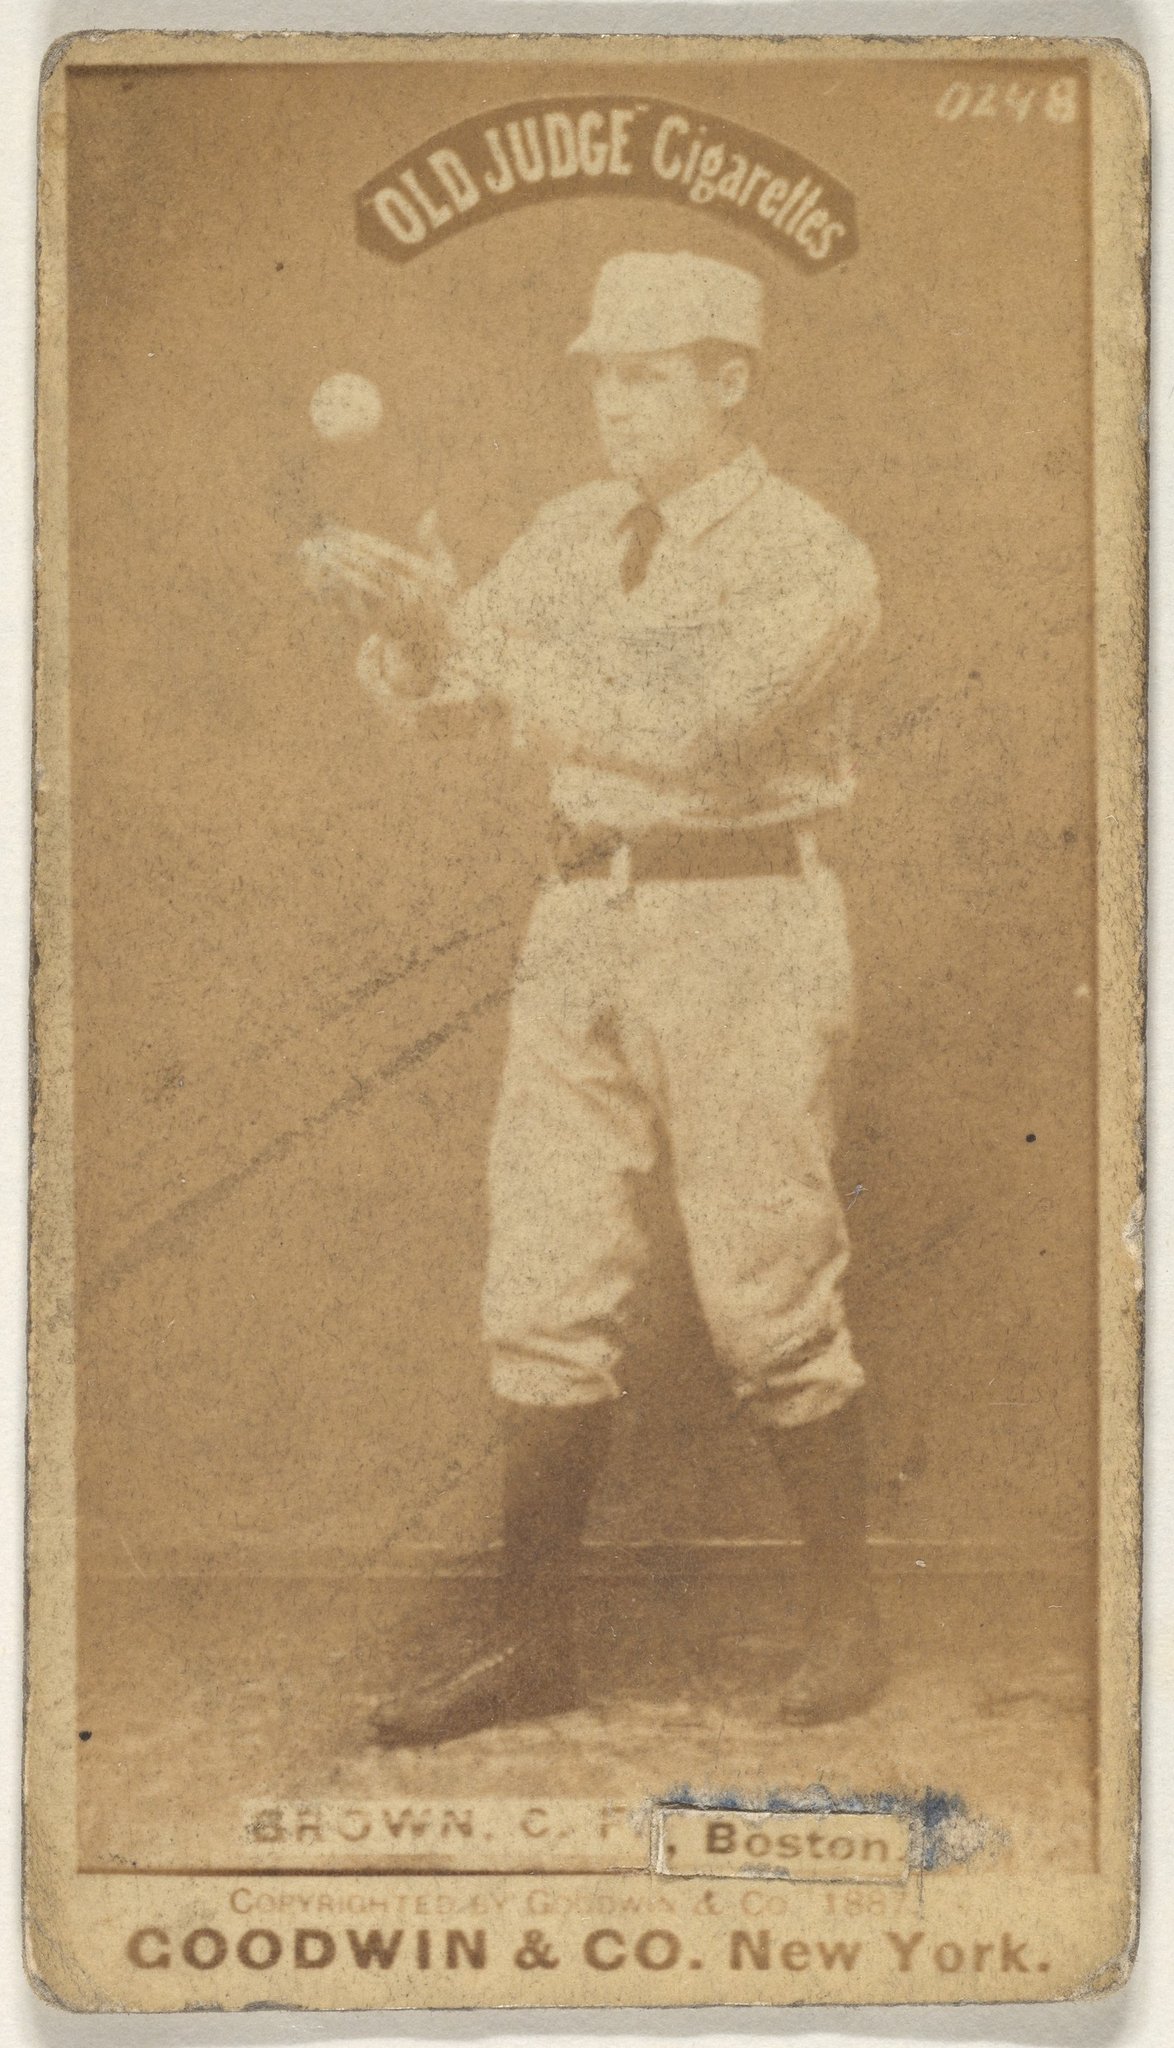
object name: baseball card, photograph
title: Brown, Center Field, Boston, from the Old Judge series (N172) for Old Judge Cigarettes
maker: goodwin & company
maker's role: publisher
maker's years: 1850-1950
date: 1887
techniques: albumen silver print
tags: men,portraits,baseball,athletes